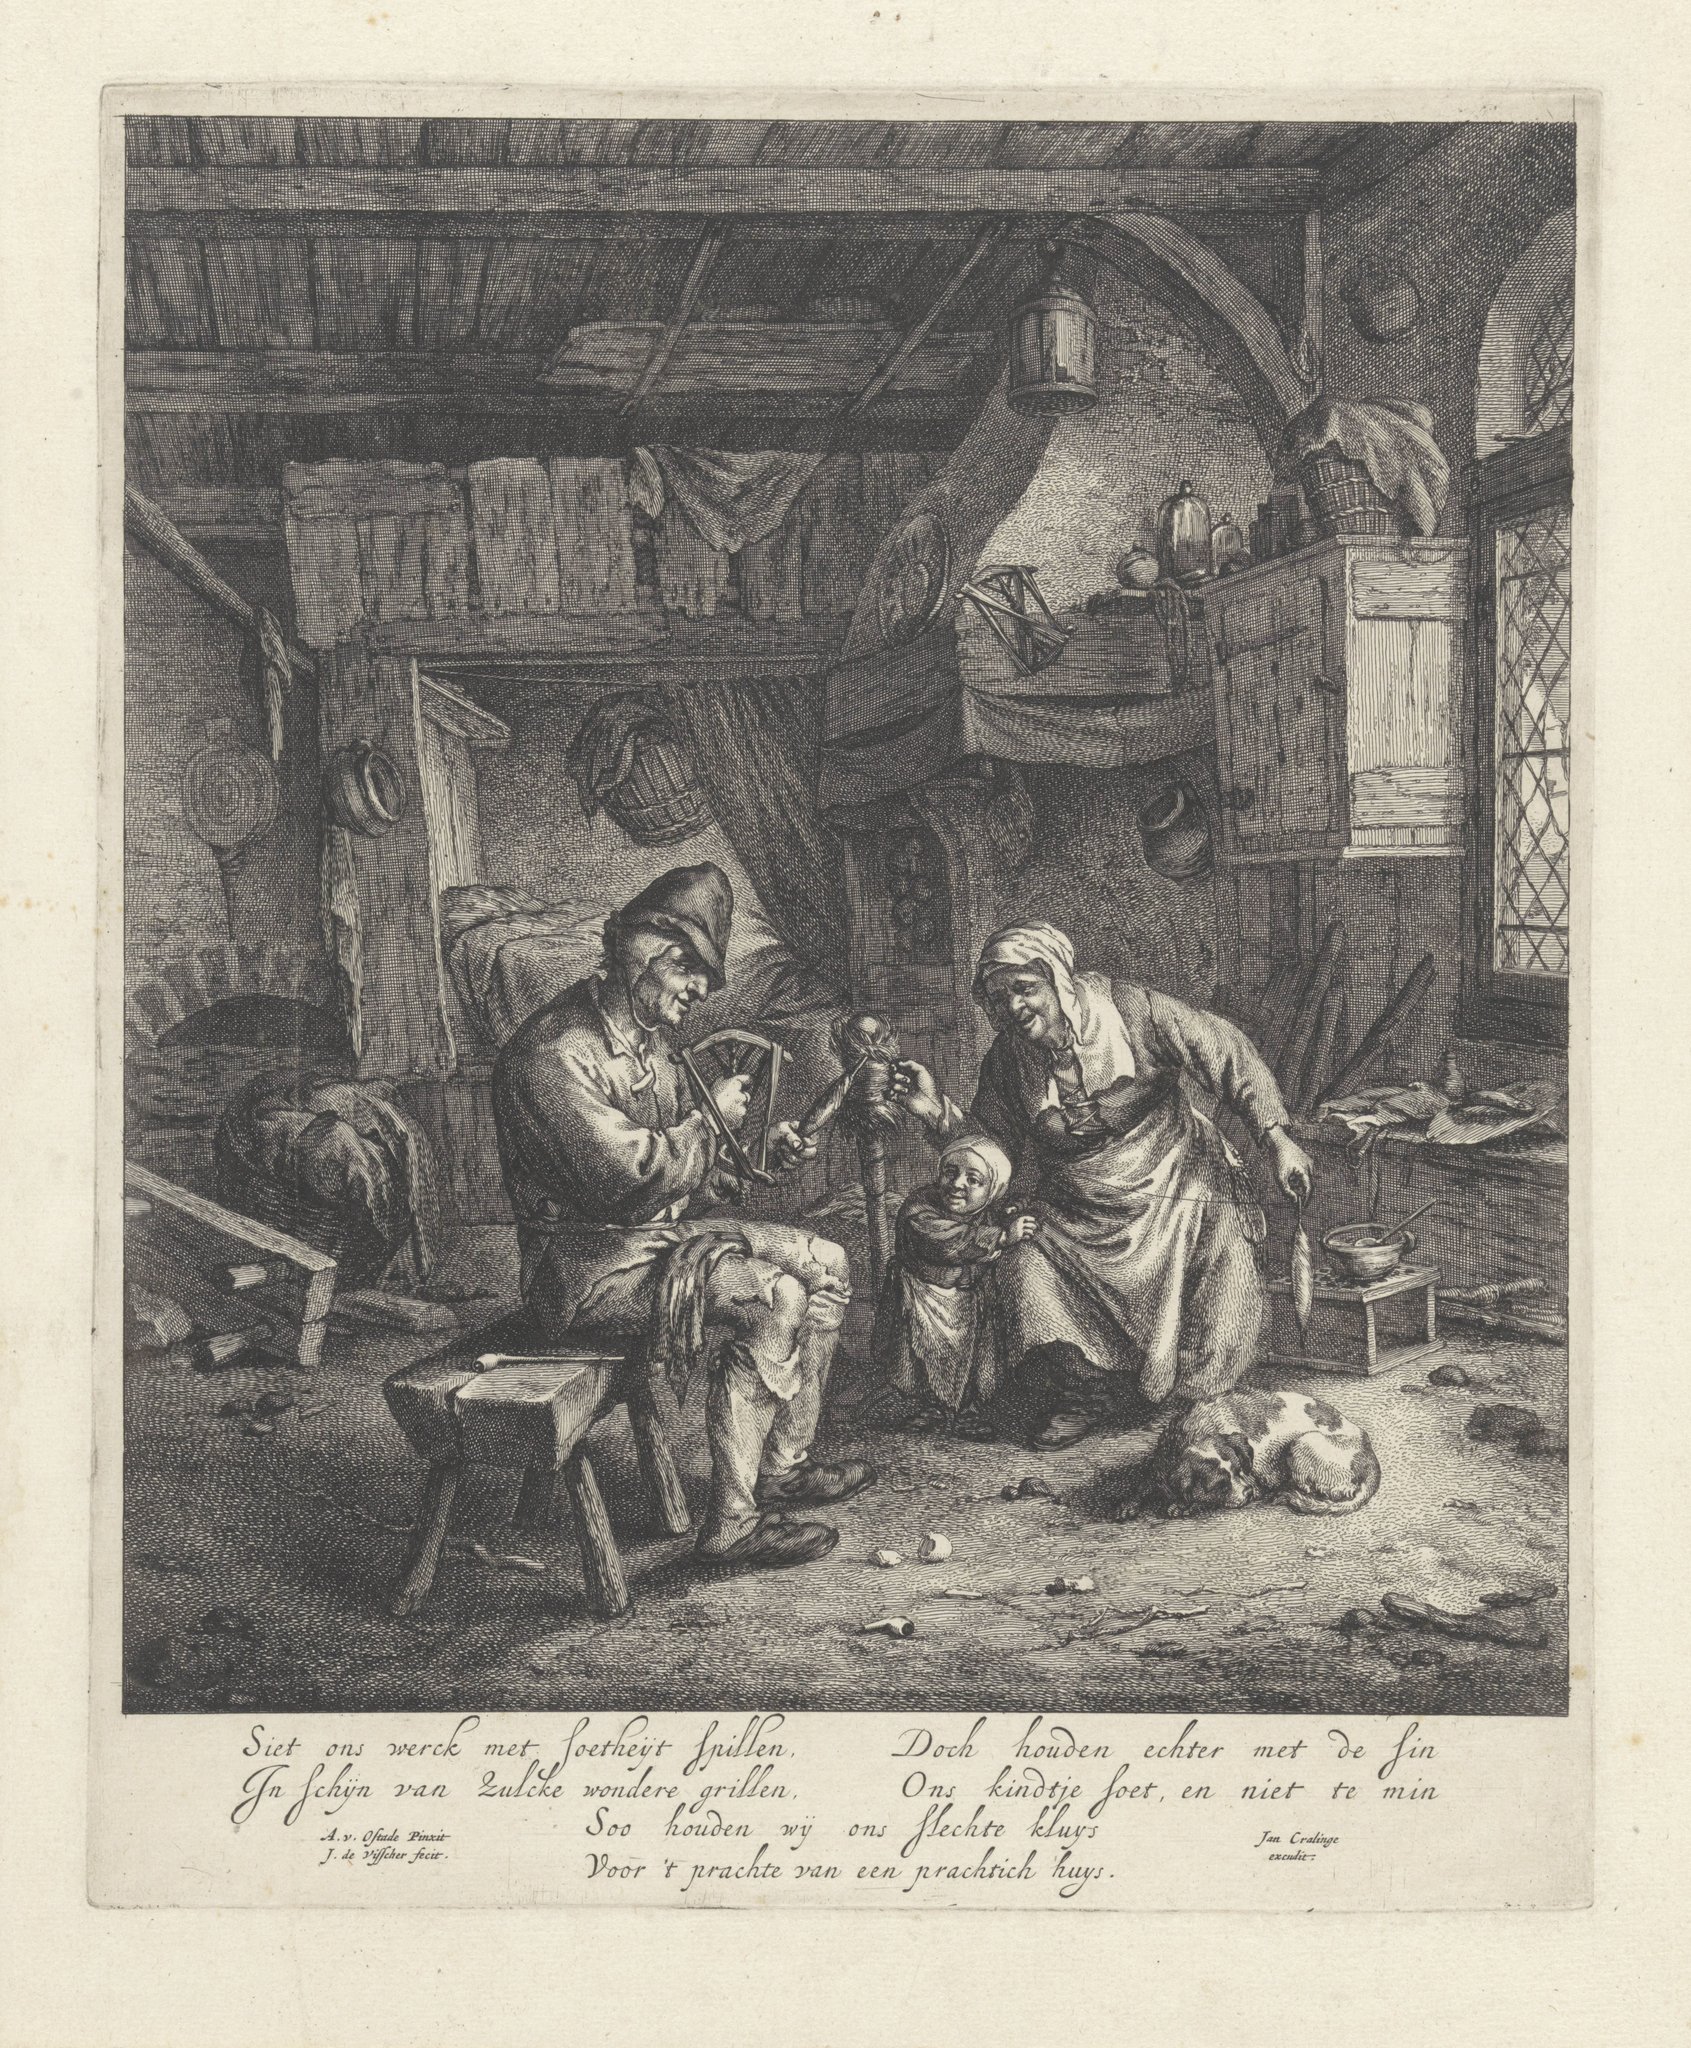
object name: print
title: Man en een vrouw winden garen op een klos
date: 1655-1673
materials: paper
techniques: etching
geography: amsterdam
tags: pipe ~ tobacco, winding of yarn on reels or spools, dog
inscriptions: collector's mark: Lugt 240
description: In een rommelig interieur zijn een man en een vrouw bezig om garen op klossen de winden. Tussen hen in staat een kind dat, leunend op het been van de vrouw, toekijkt. Tussen de eierschalen en gebroken pijpjes ligt een hond te slapen.